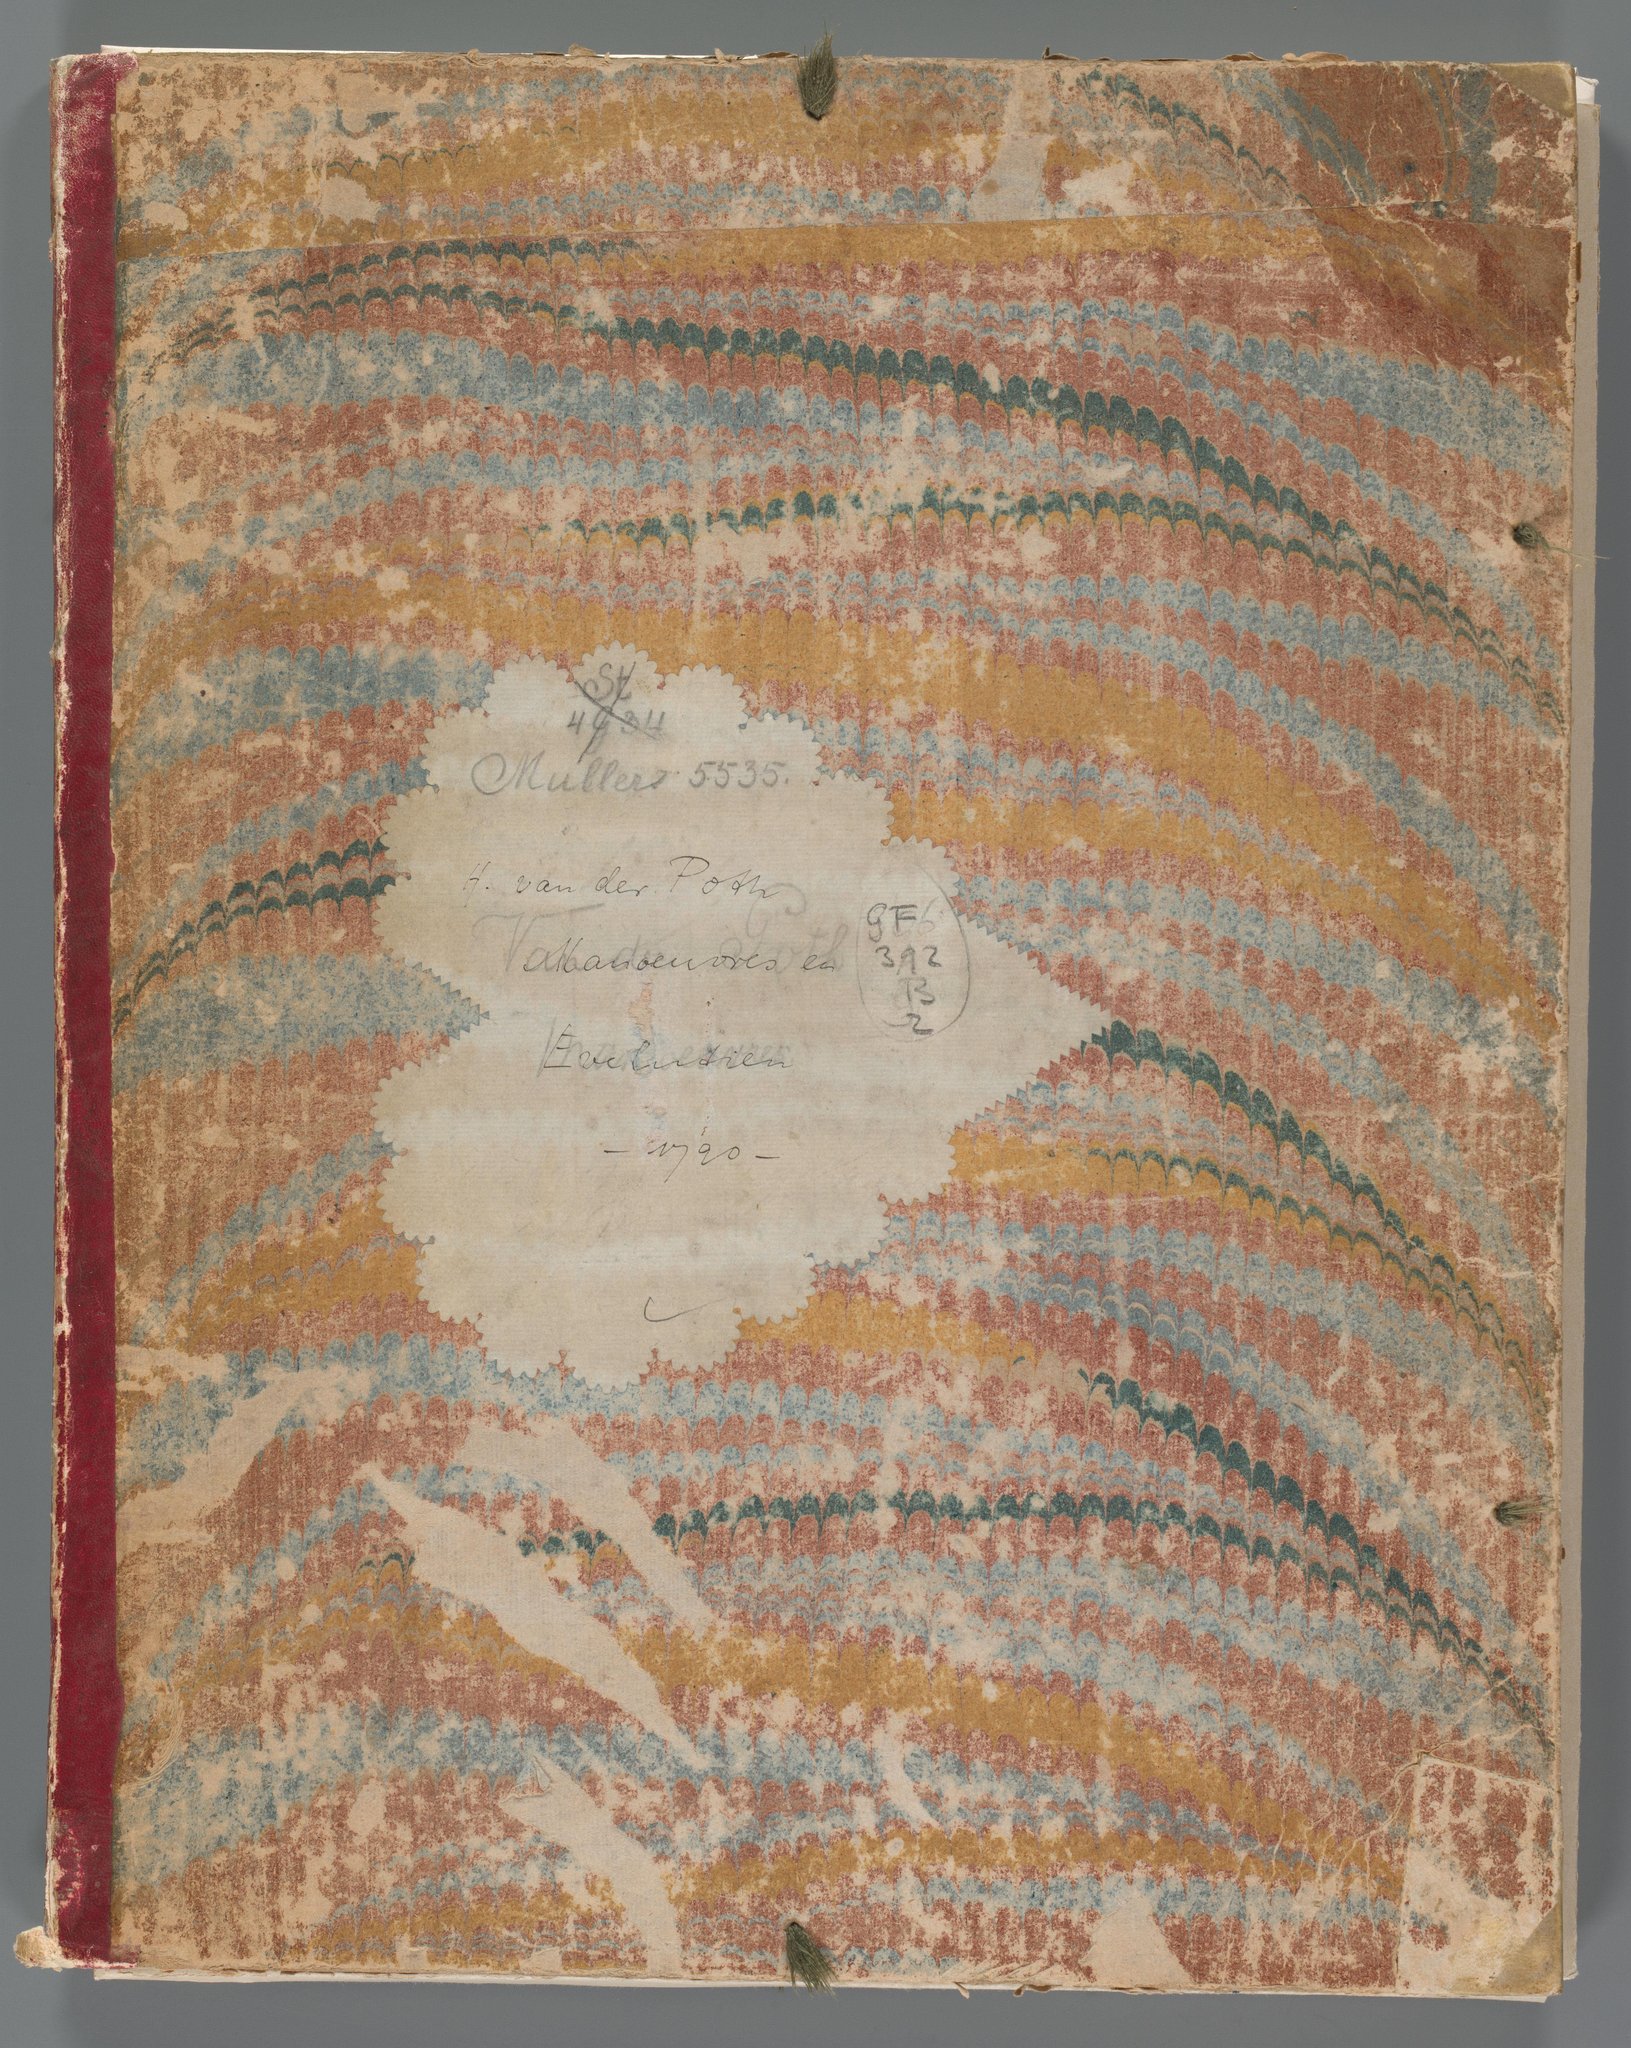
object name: drawing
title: Ensemble kaarten en tekeningen van adjudant Hendrik van der Poth ten tijde van de Brits-Russische expeditie naar Noord-Holland in 1799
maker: hendrik van der poth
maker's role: draughtsman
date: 1795-1803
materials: cardboard, paper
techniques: calligraphy, writing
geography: netherlands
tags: manoeuvre ~ military training, fortifications, military engineering, delft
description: Ensemble van 54 kaarten, tekeningen en gekalligrafeerde rapporten vervaardigd door de adjudant Hendrik van der Poth ten tijde van de Brits-Russische expeditie naar Noord-Holland in 1799, plus werk van enkele jaren daarvoor en daarna. Veel van de tekeningen hebben ook betrekking op de oefeningen van de Bataafsche Gewapende Burgermacht van Delft onder commando van A. Oltmans. Opgeborgen in een grote kartonnen map en onderverdeeld in acht submappen.